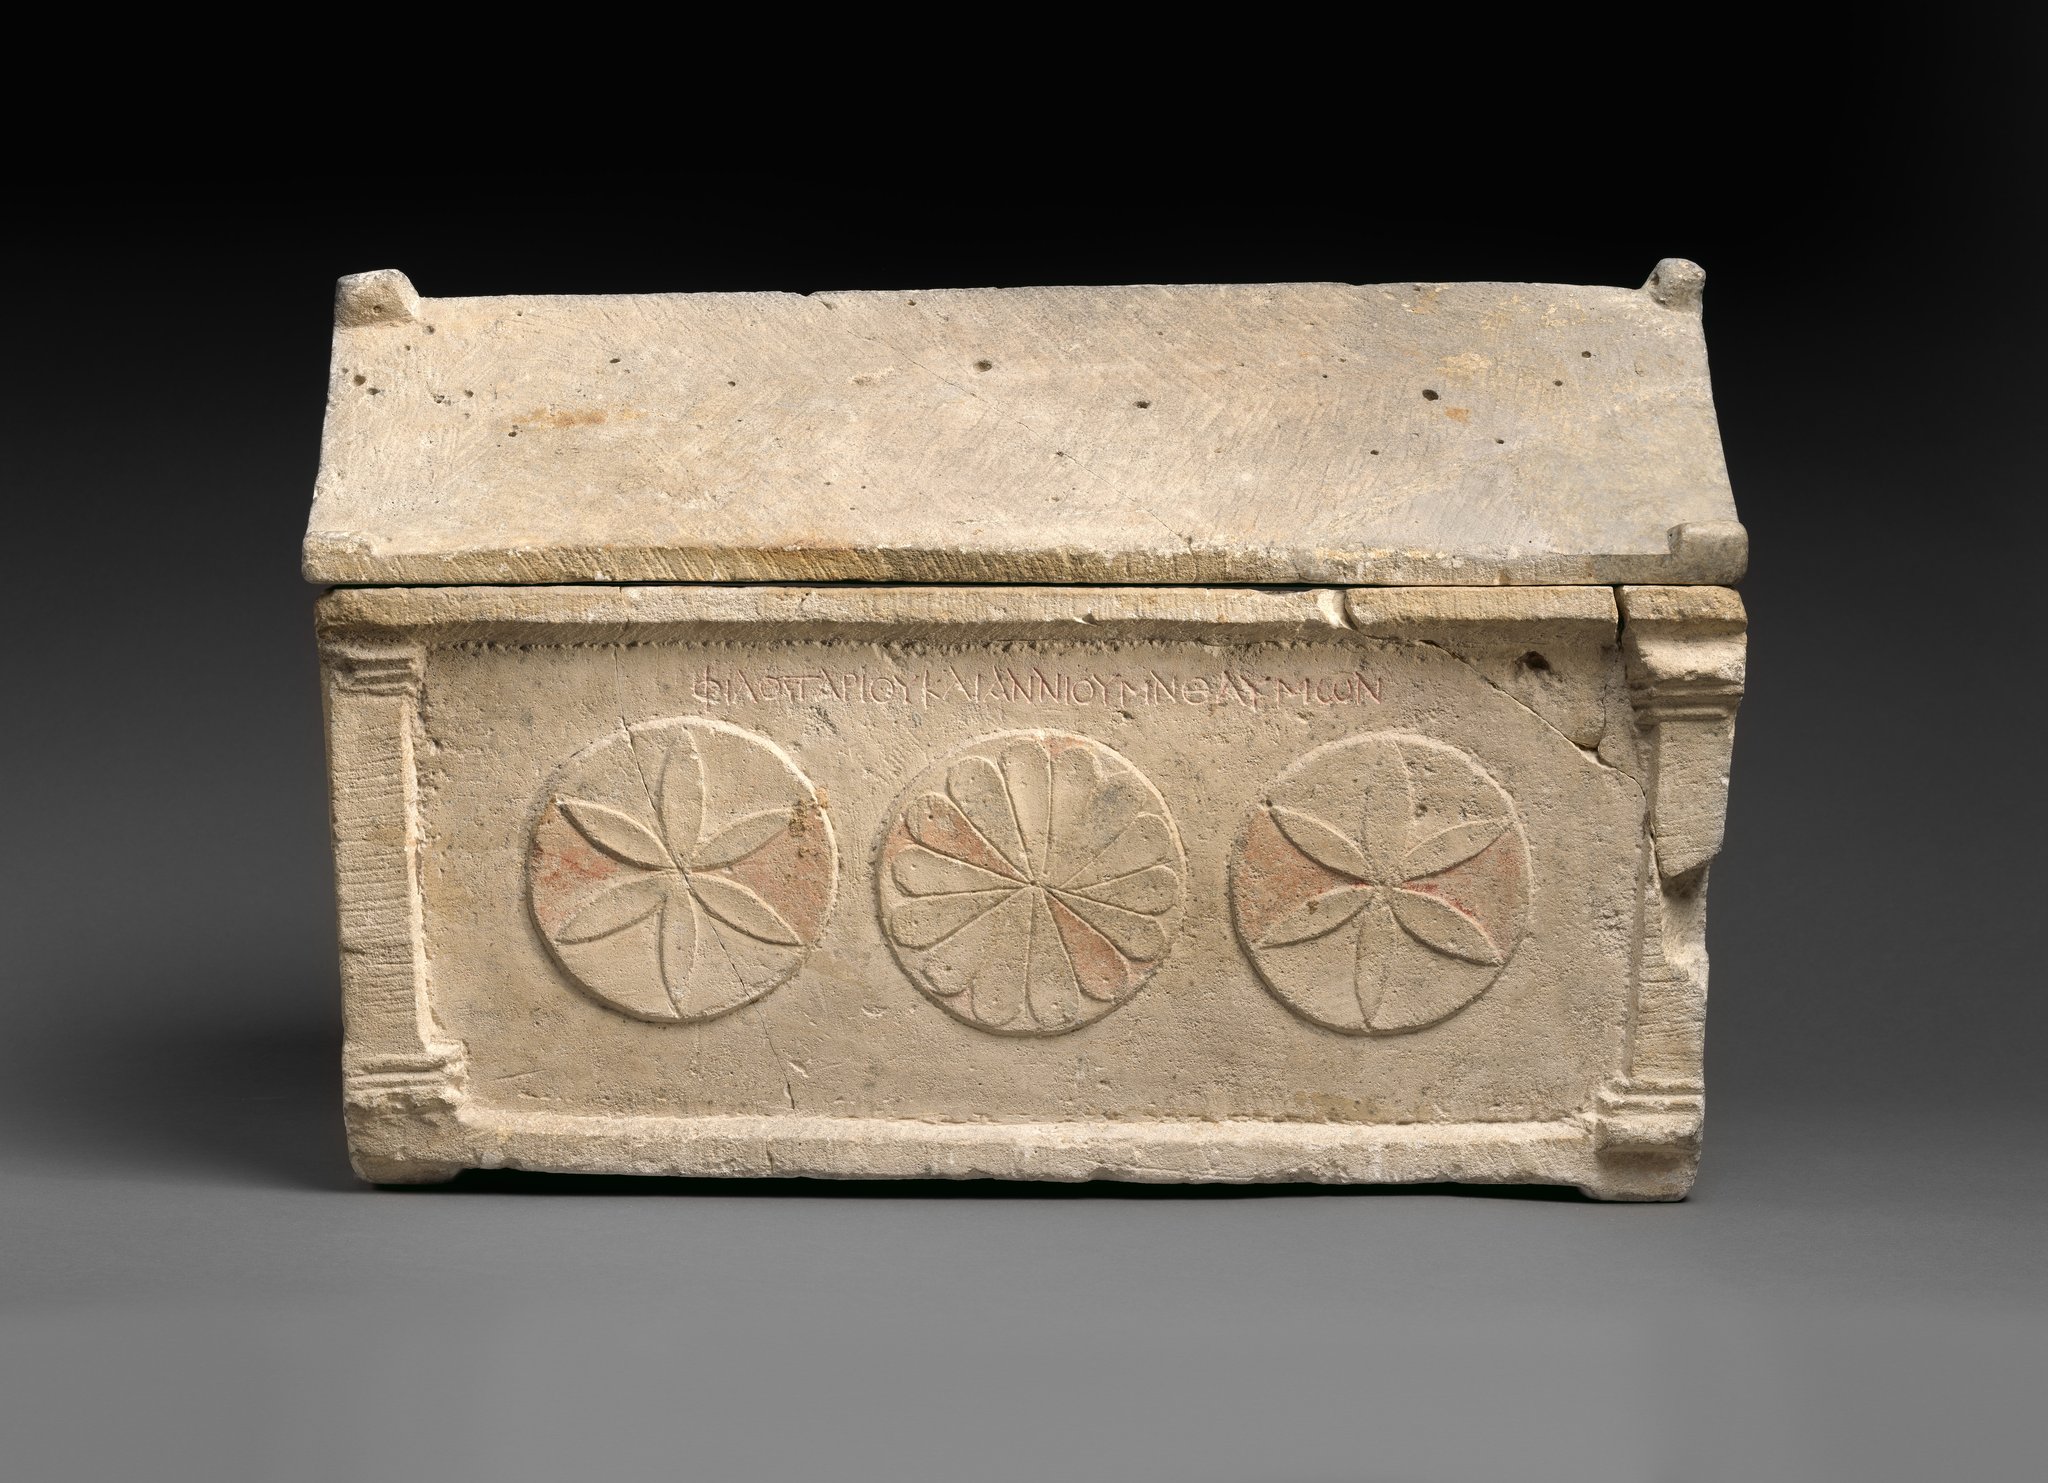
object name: ossuary with lid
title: Limestone ossuary with lid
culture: roman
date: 1-100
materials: limestone, paint